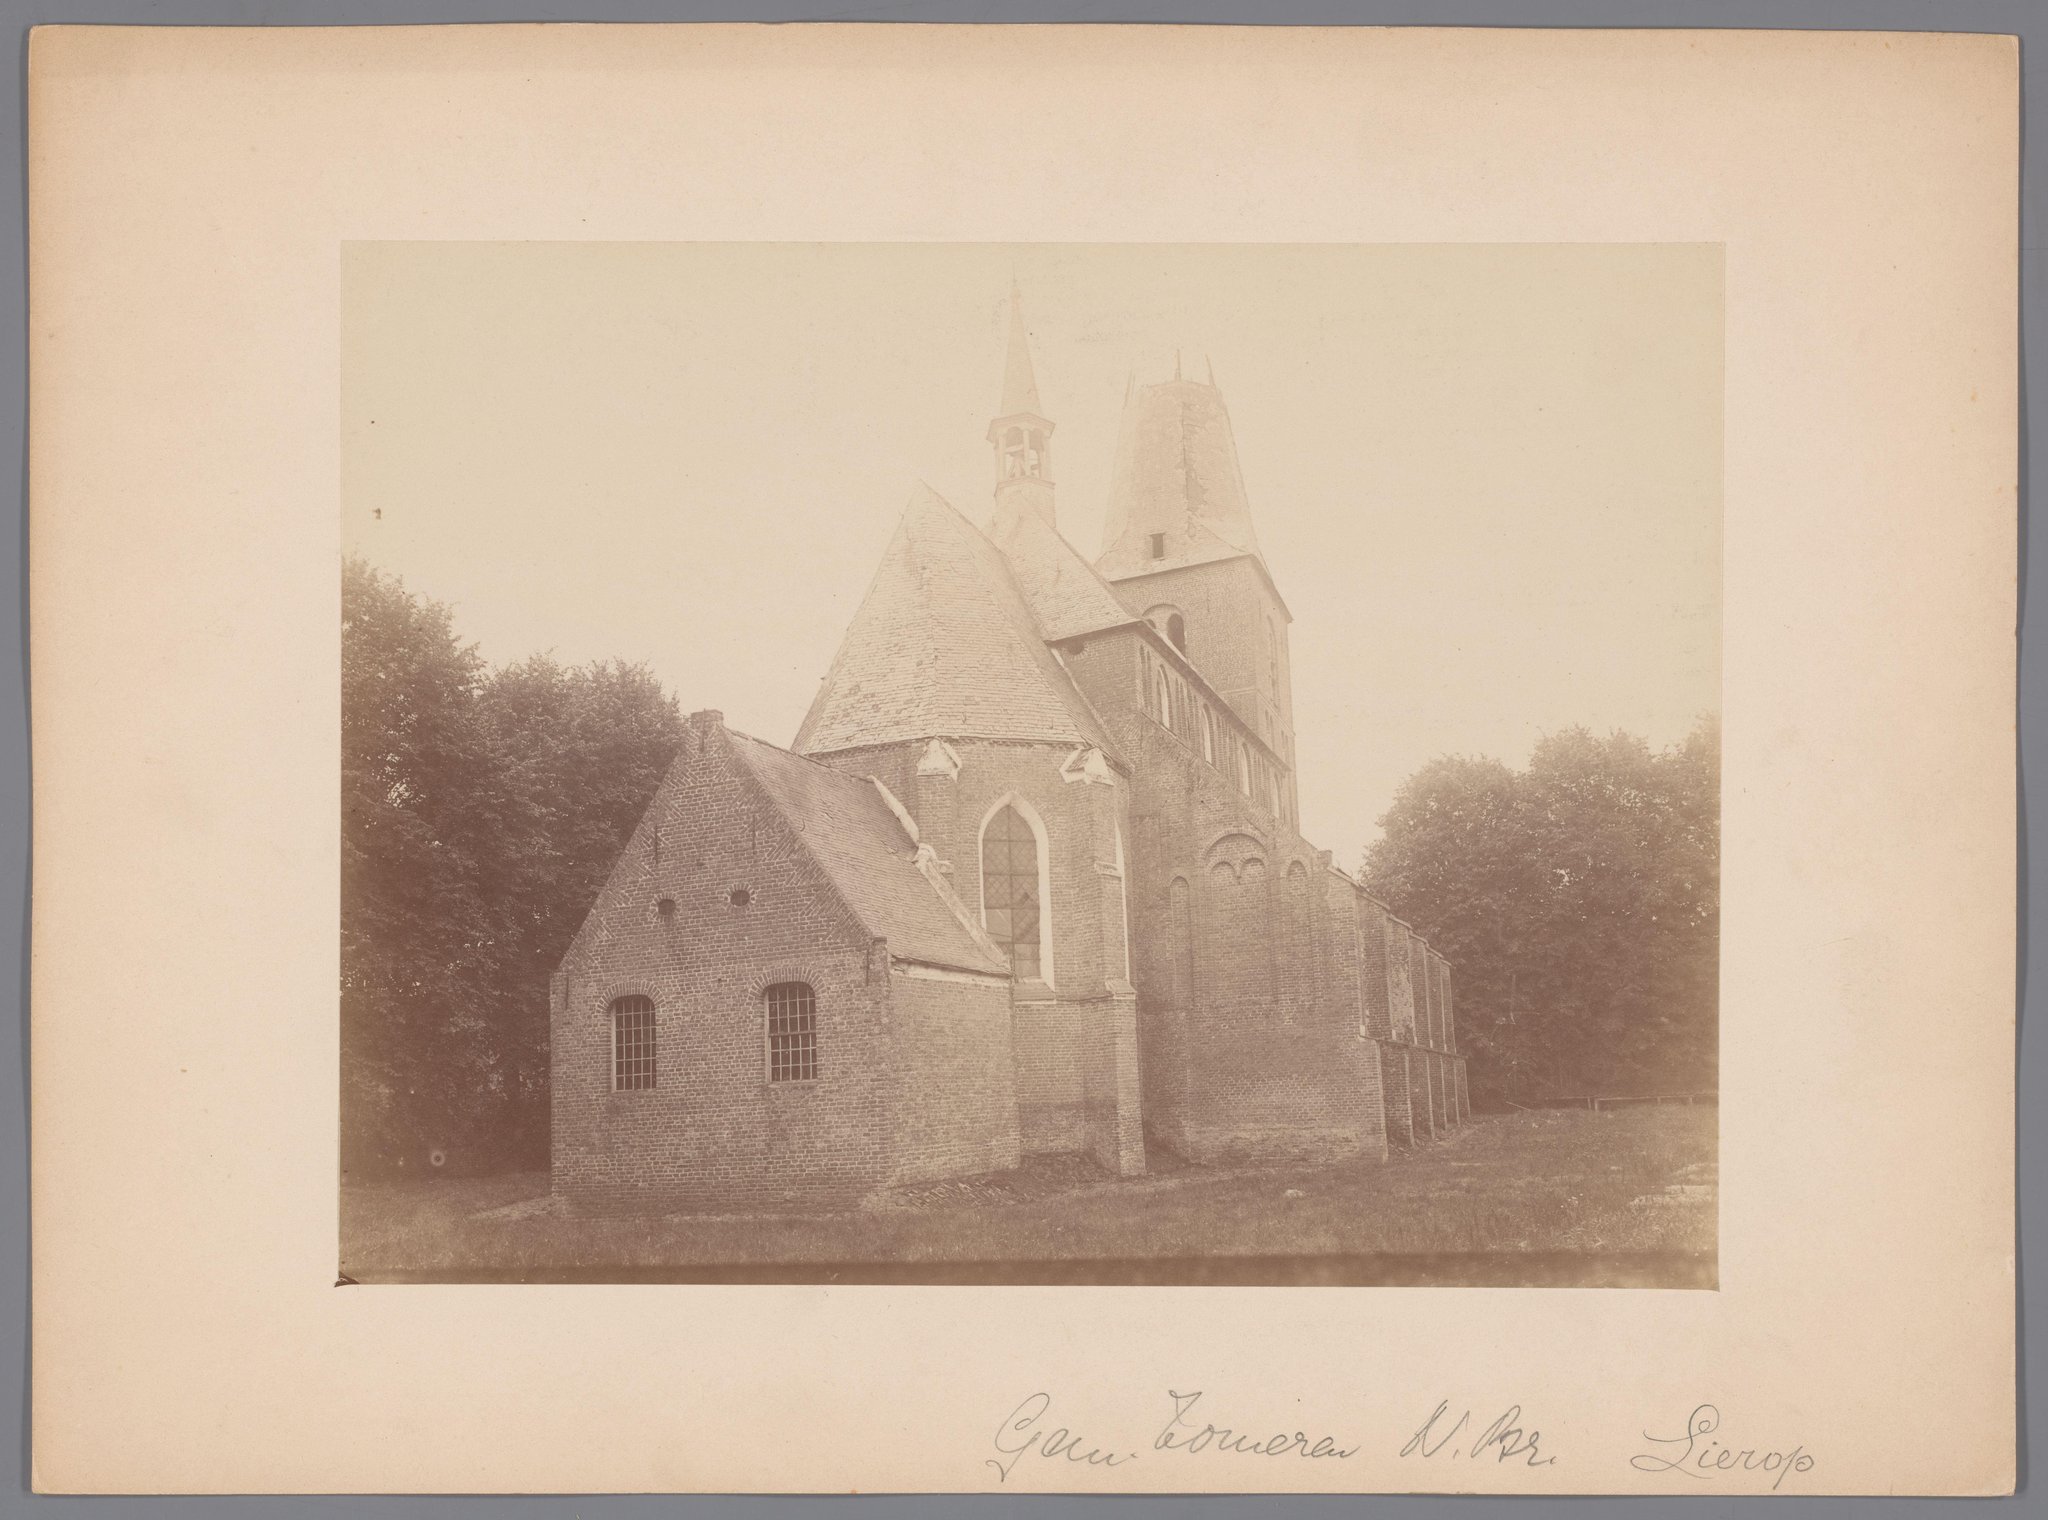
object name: photograph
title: Oostzijde van de Rooms-Katholieke kerk te Lierop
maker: anoniem (monumentenzorg)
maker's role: fotograaf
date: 1891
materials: cardboard, photographic support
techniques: albumen print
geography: lierop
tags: church (exterior)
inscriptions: annotation: ‘R.K. Kerk te Lierop bij Helmond/ Juli 1891’, annotation: ‘Gem. Zomeren N.Br. Lierop’